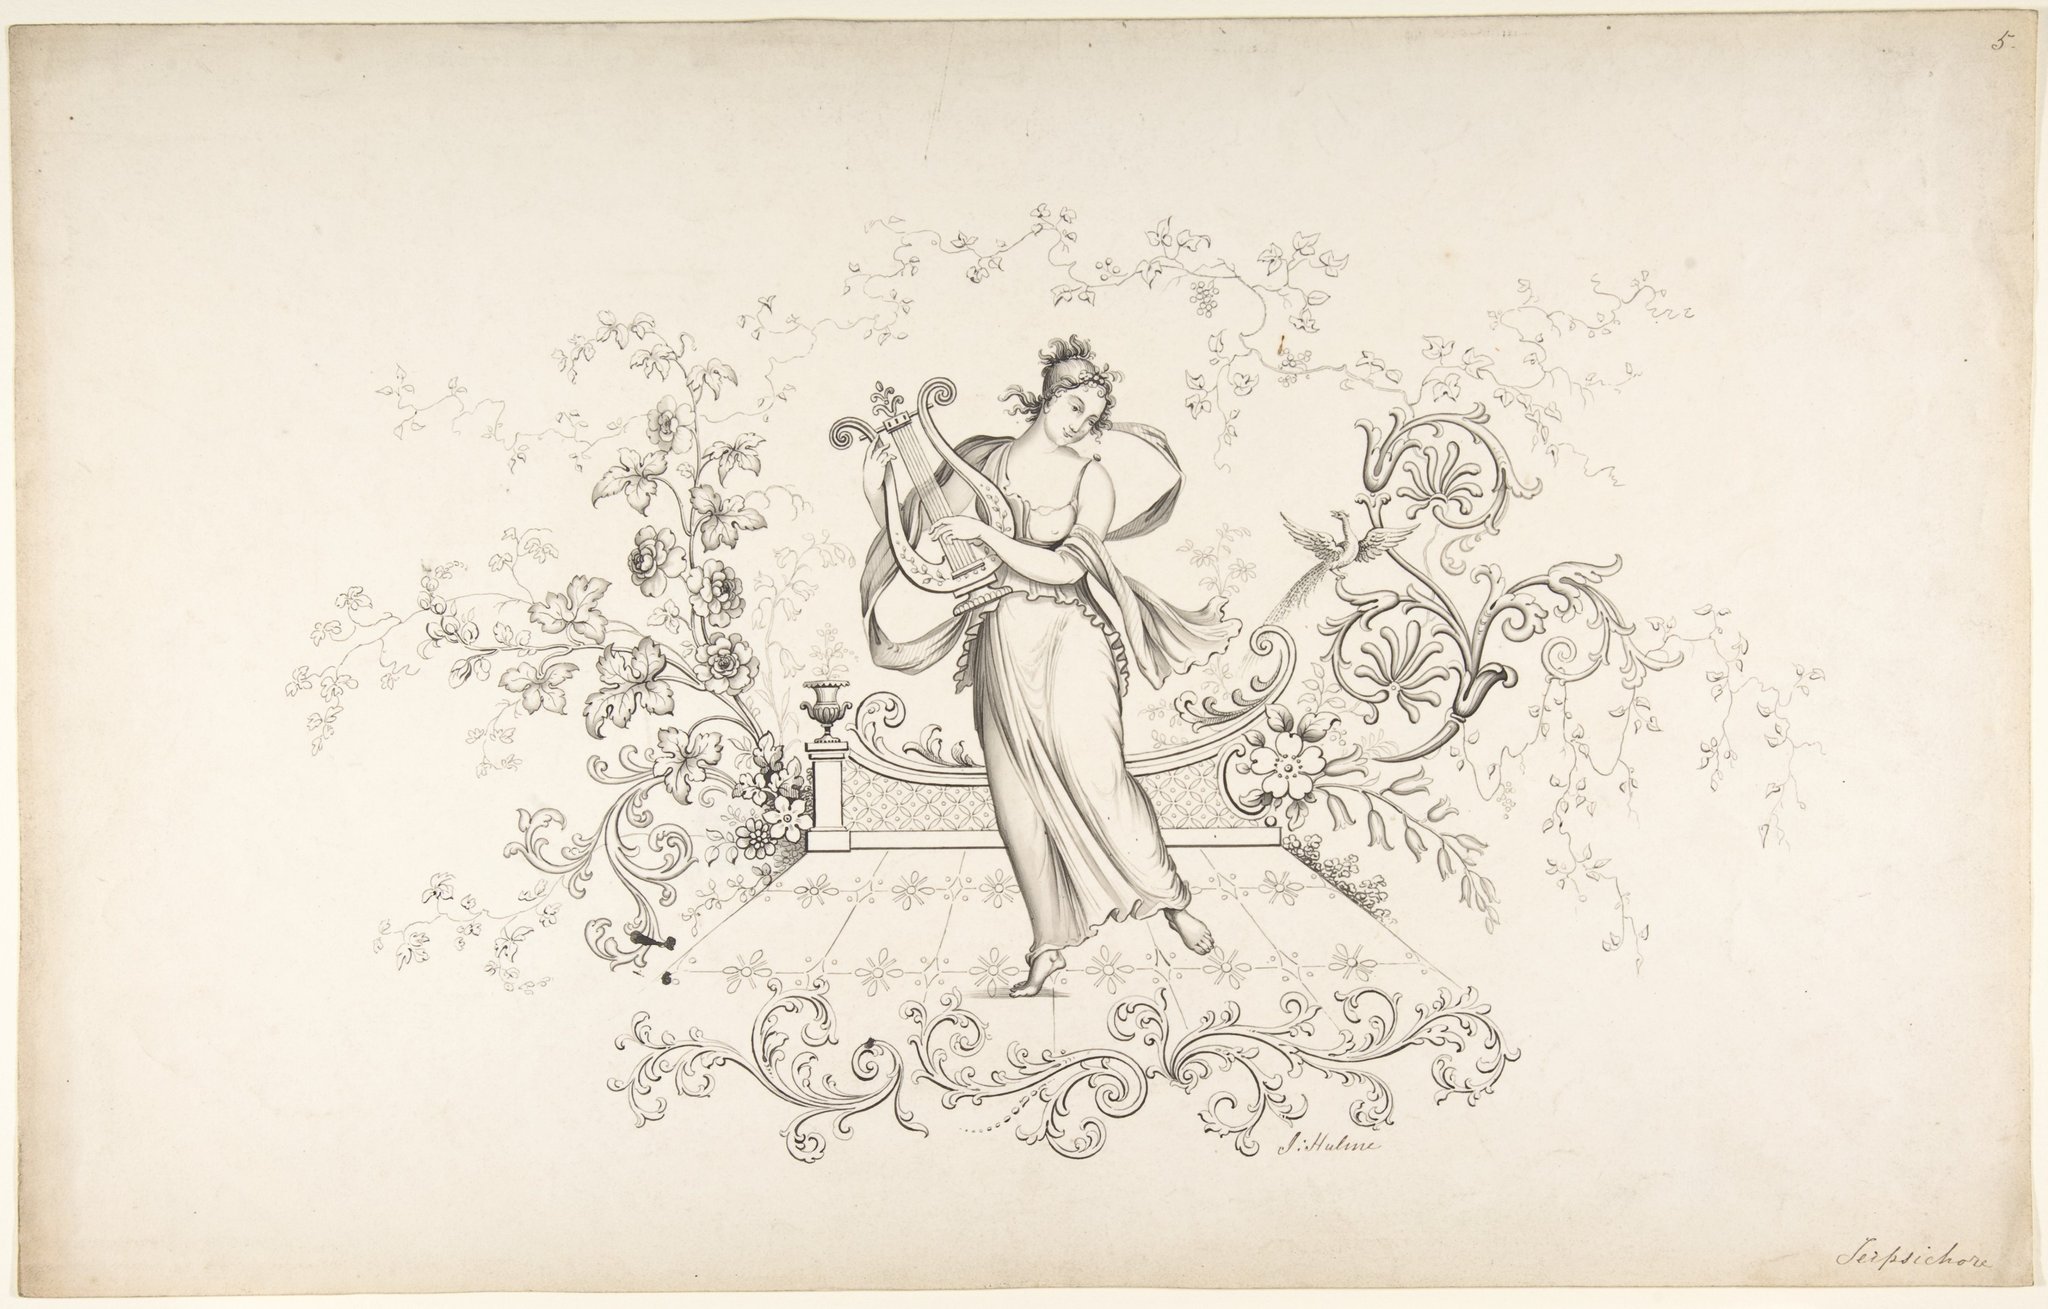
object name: drawing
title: Design for Panel Decoration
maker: j. hulme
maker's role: artist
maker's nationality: british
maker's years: 1800-1880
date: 1828-1840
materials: ink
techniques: brush, pen, wash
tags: musical instruments,birds,women,flowers,leaves